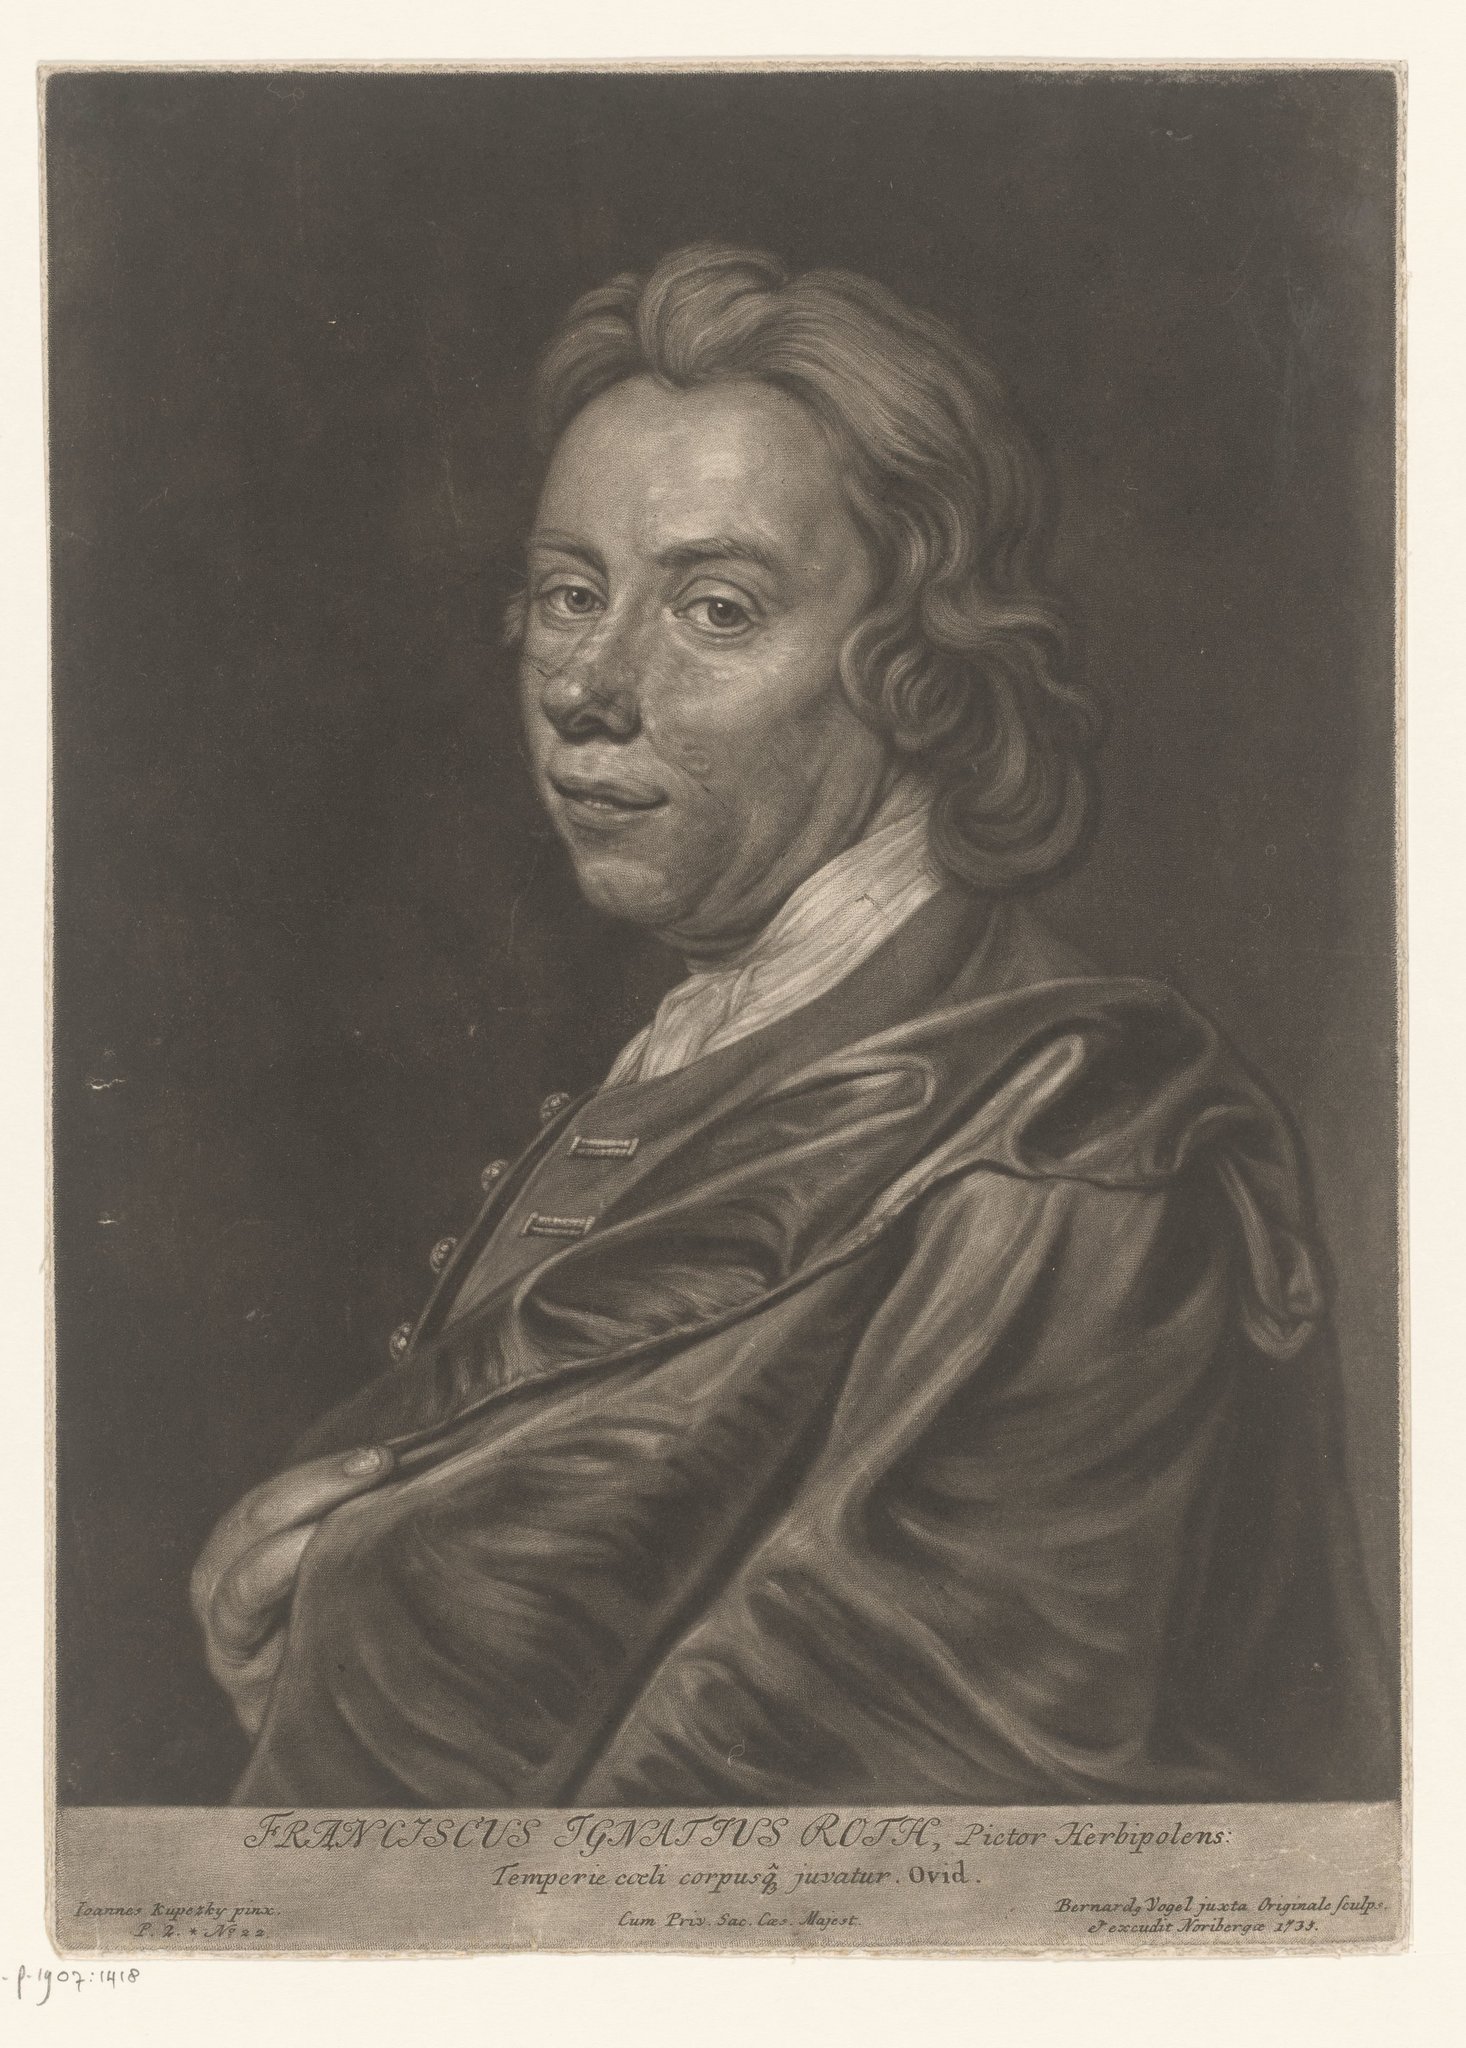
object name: print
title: Portret van Franz Ignaz Roth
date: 1735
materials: paper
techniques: mezzotint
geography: nuremberg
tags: franz ignaz roth, historical persons, armorial bearing, heraldry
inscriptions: collector's mark: Lugt 2228